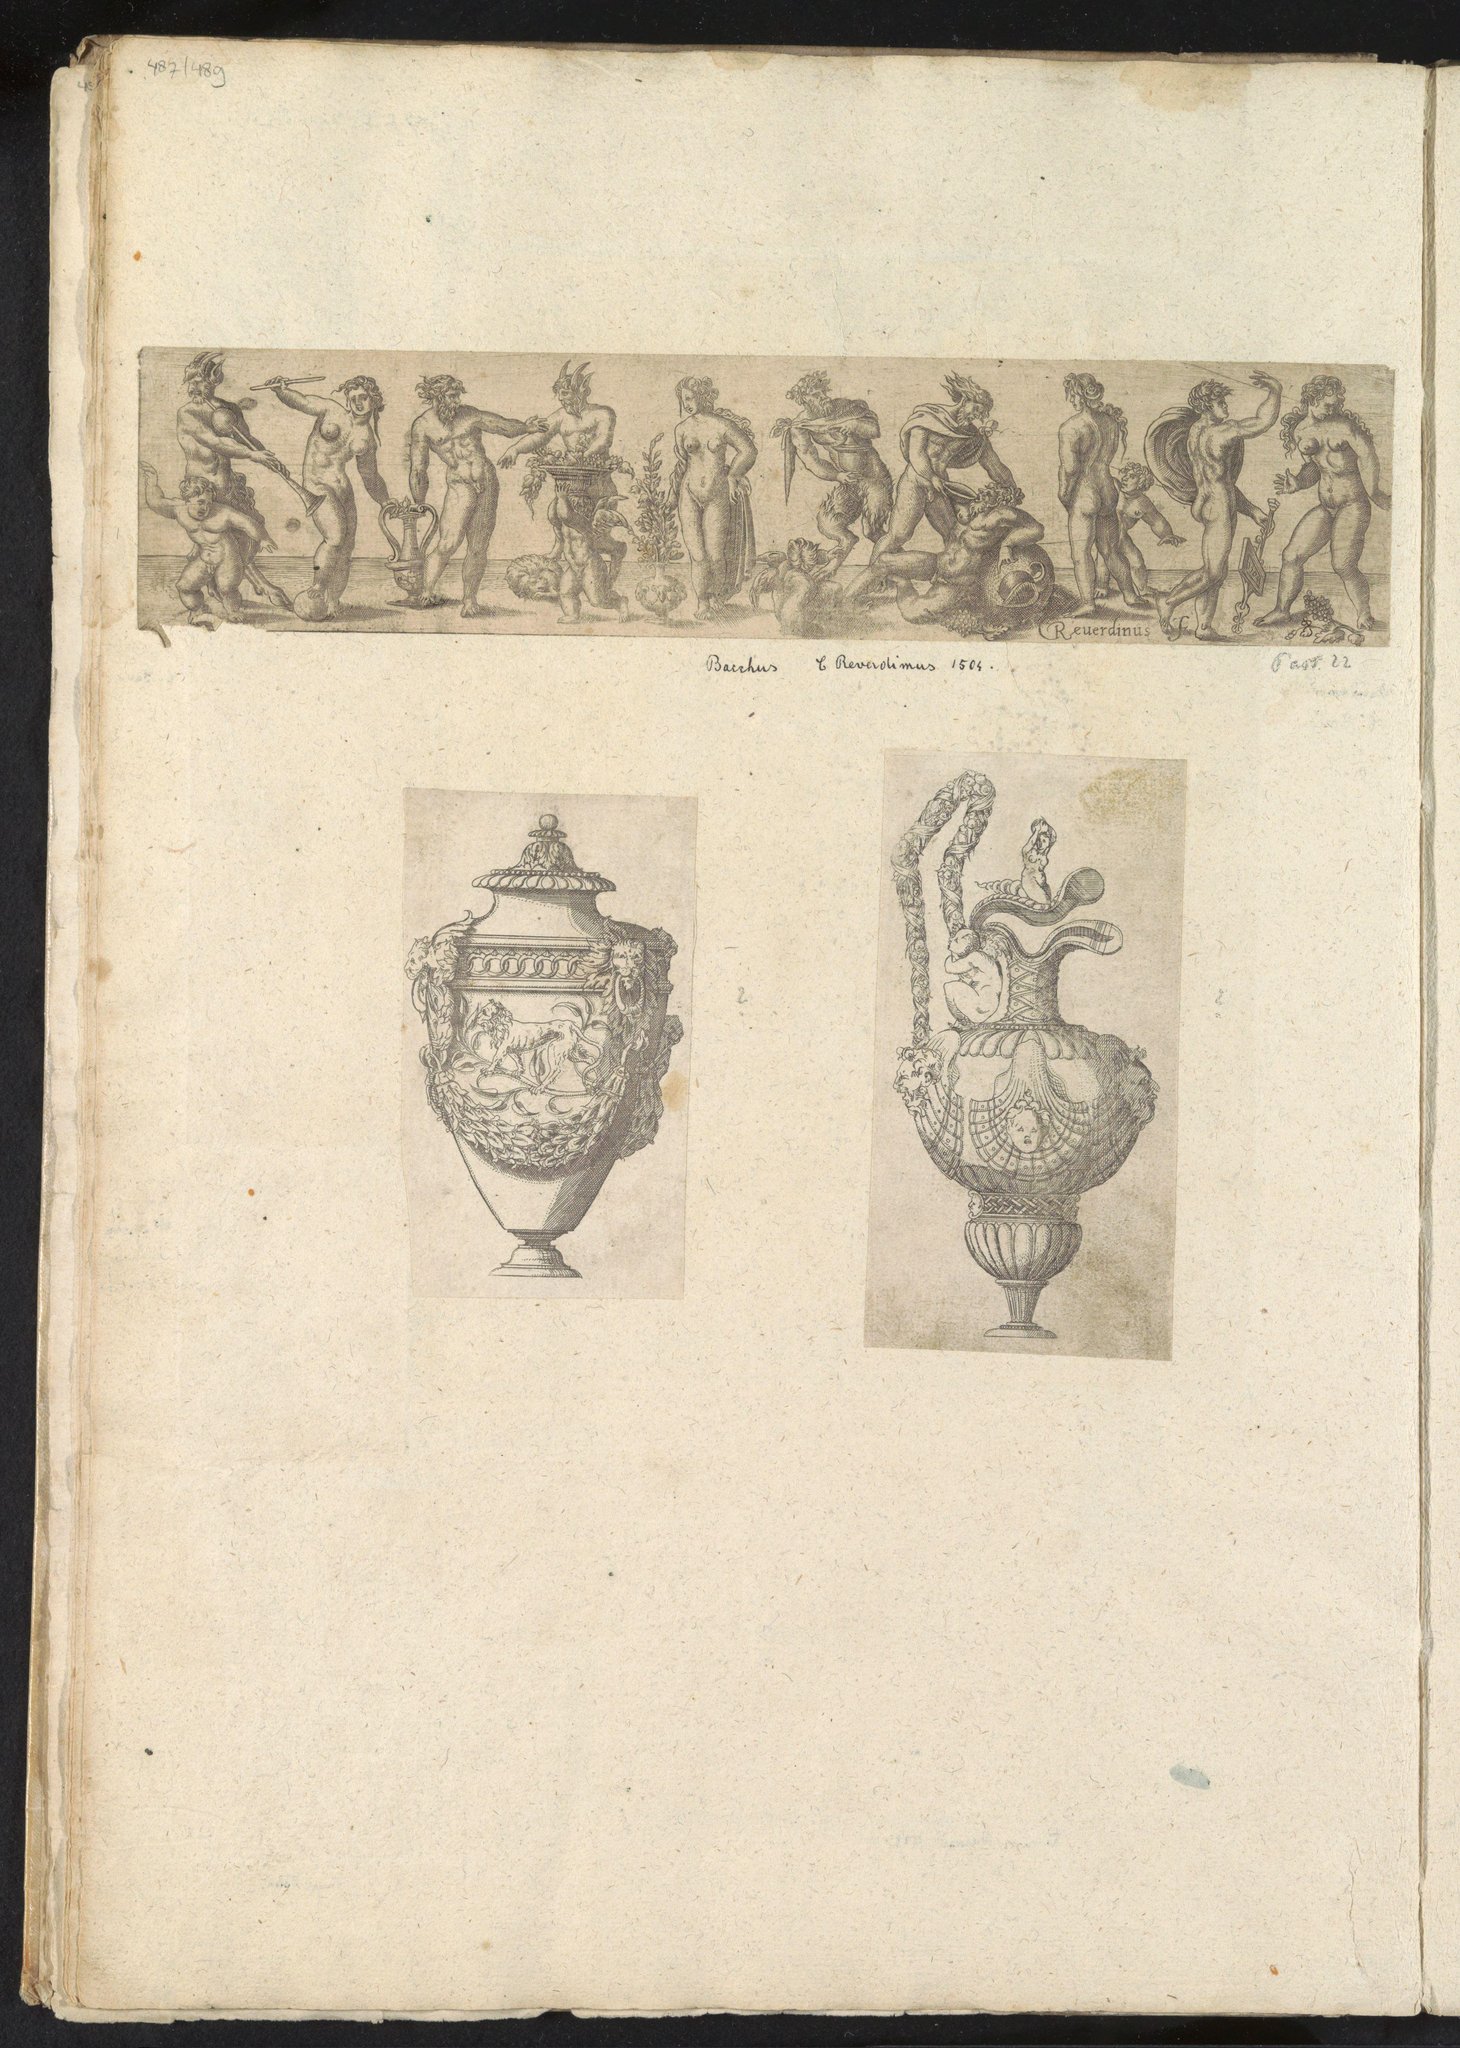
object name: ornament print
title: Albumblad met drie prenten met een urn, een kan en een fries met saters en bacchanten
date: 1500-1599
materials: paper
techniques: engraving, etching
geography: france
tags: kitchen-utensils: cauldron, maenad(s), female bacchant(es), satyr(s) (in general), urn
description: Albumblad met drie uitgeknipte prenten: een urn, een kan en een fries met saters en bacchanten.